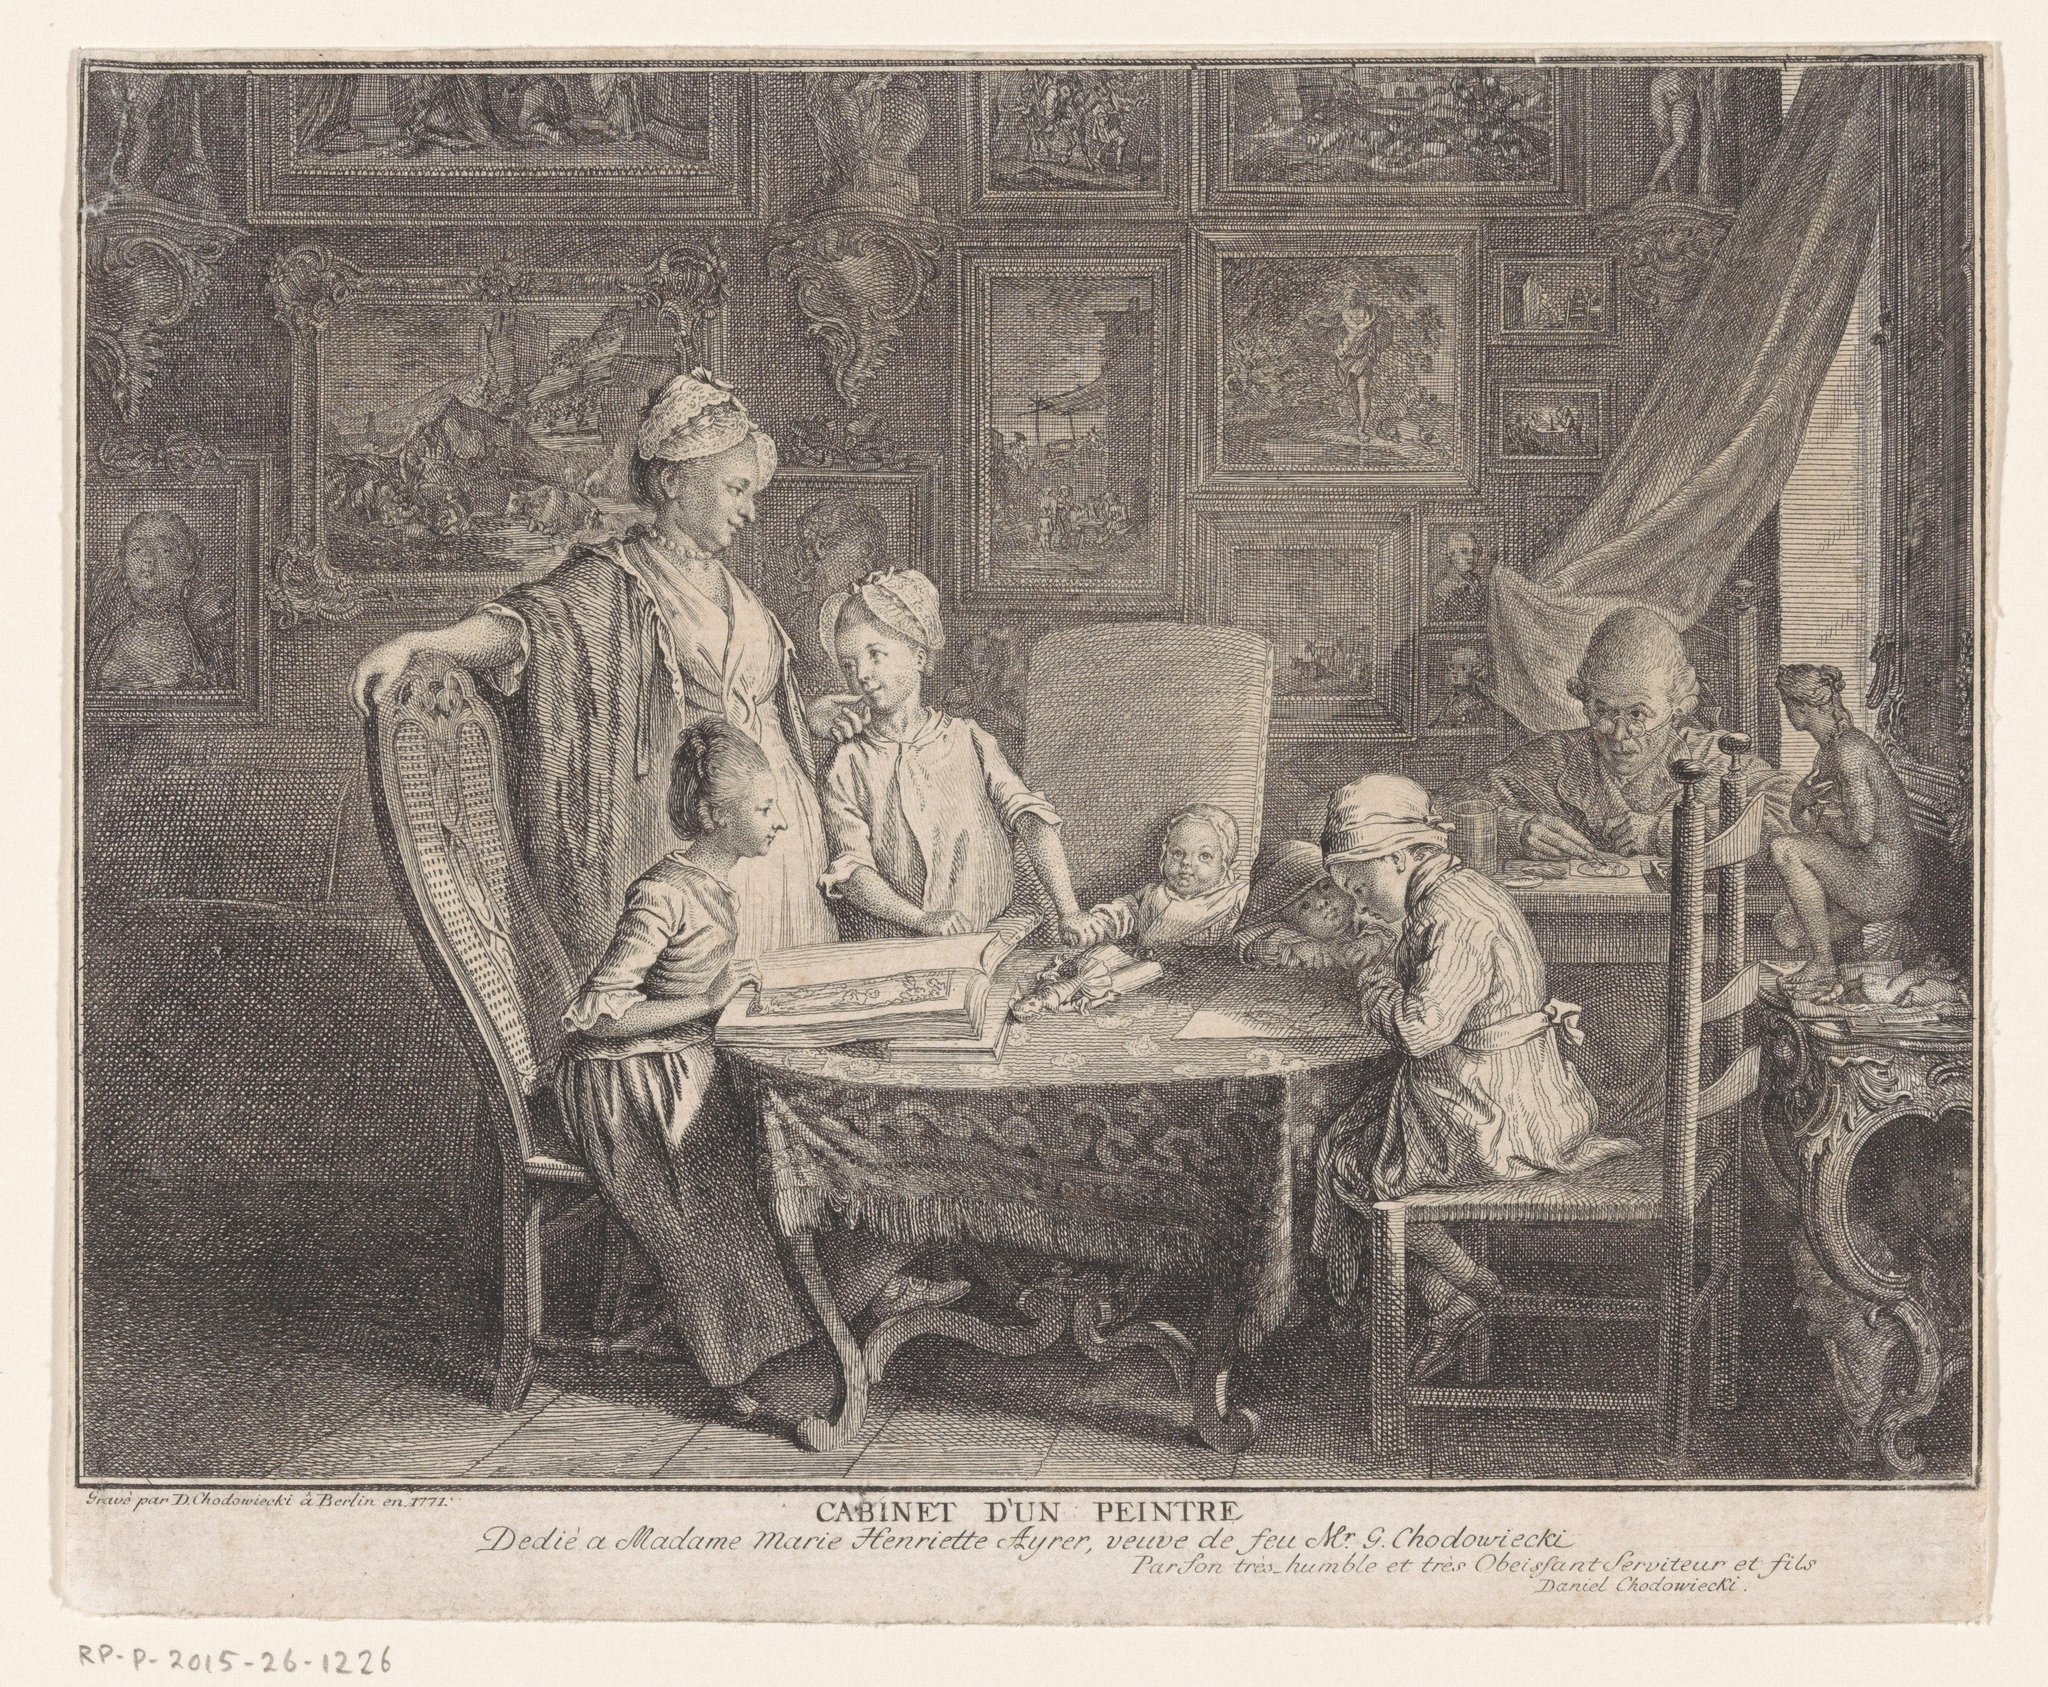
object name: print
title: The Artist and his Family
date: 1771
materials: paper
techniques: etching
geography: berlin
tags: berlin, print maker, draughtsman, daniel nikolaus chodowiecki, family life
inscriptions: date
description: De kunstenaar, zijn echtgenote en vijf kinderen in een vertrek waarvan een wand vol hangt met schilderijen. Rechts een Venusbeeld. De kinderen zitten aan een tafel en kijken in een prentenalbum. Chodowiecki zit rechts aan een kleine tafel te tekenen. Volgens het onderschrift is de prent opgedragen aan Henriette Ayrer, de moeder van de kunstenaar in Danzig. Zij had haar zoon in 30 jaar niet gezien.